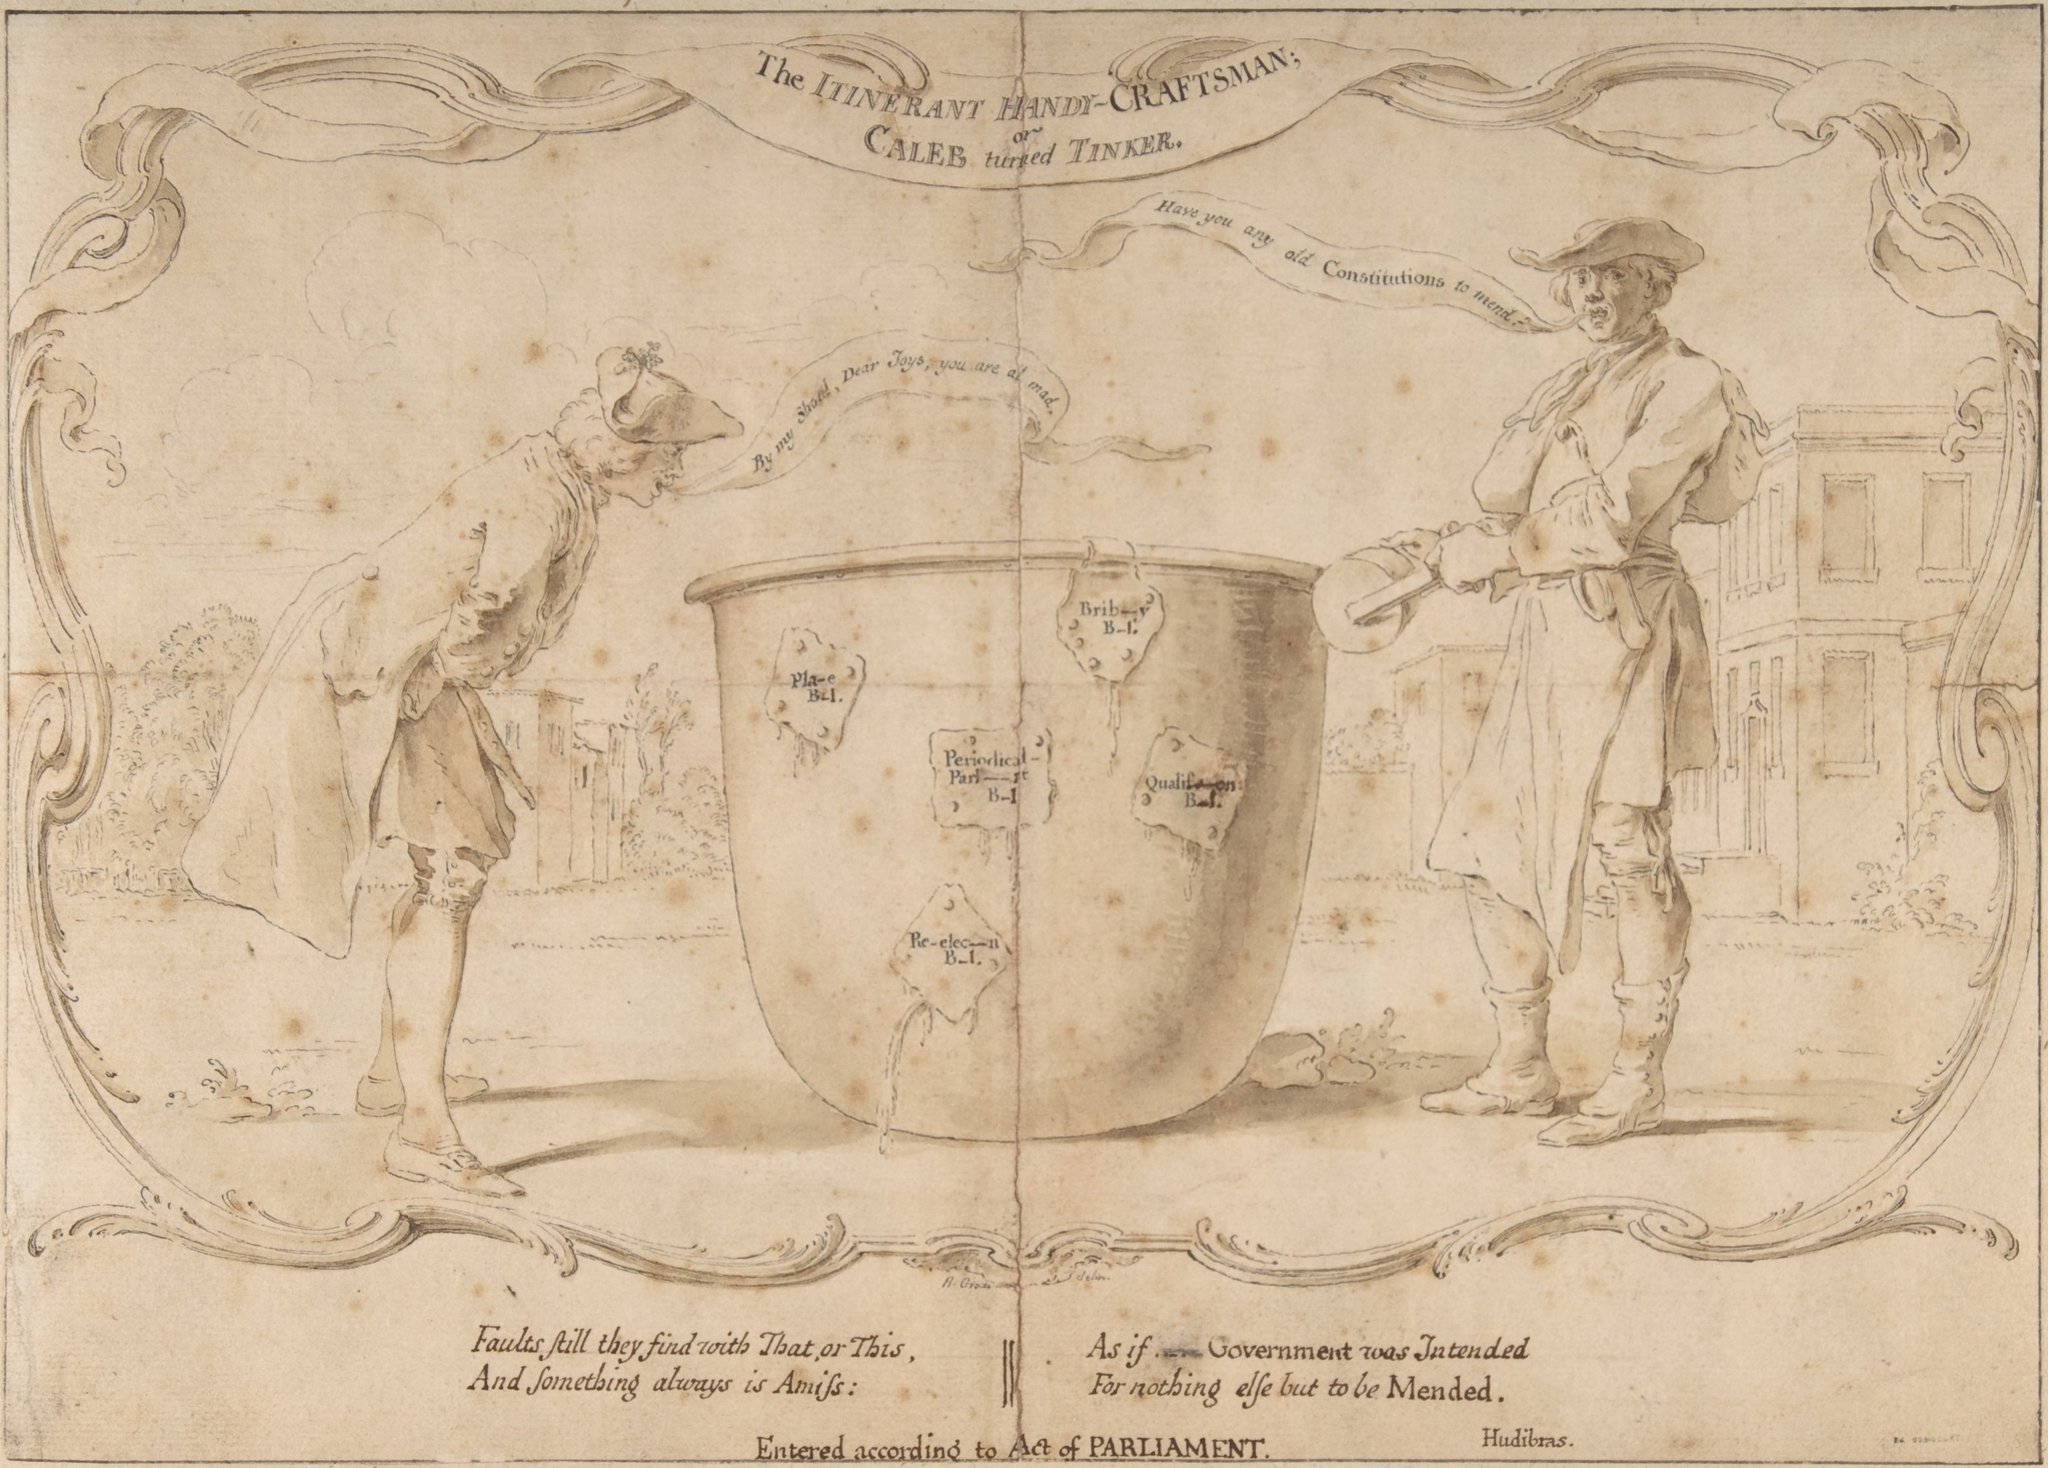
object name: drawing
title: Design for an English Political Satire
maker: hubert françois gravelot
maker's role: artist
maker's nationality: french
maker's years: 1699-1773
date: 1701-1800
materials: ink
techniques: brush, pen, wash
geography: france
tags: satire,men,politics